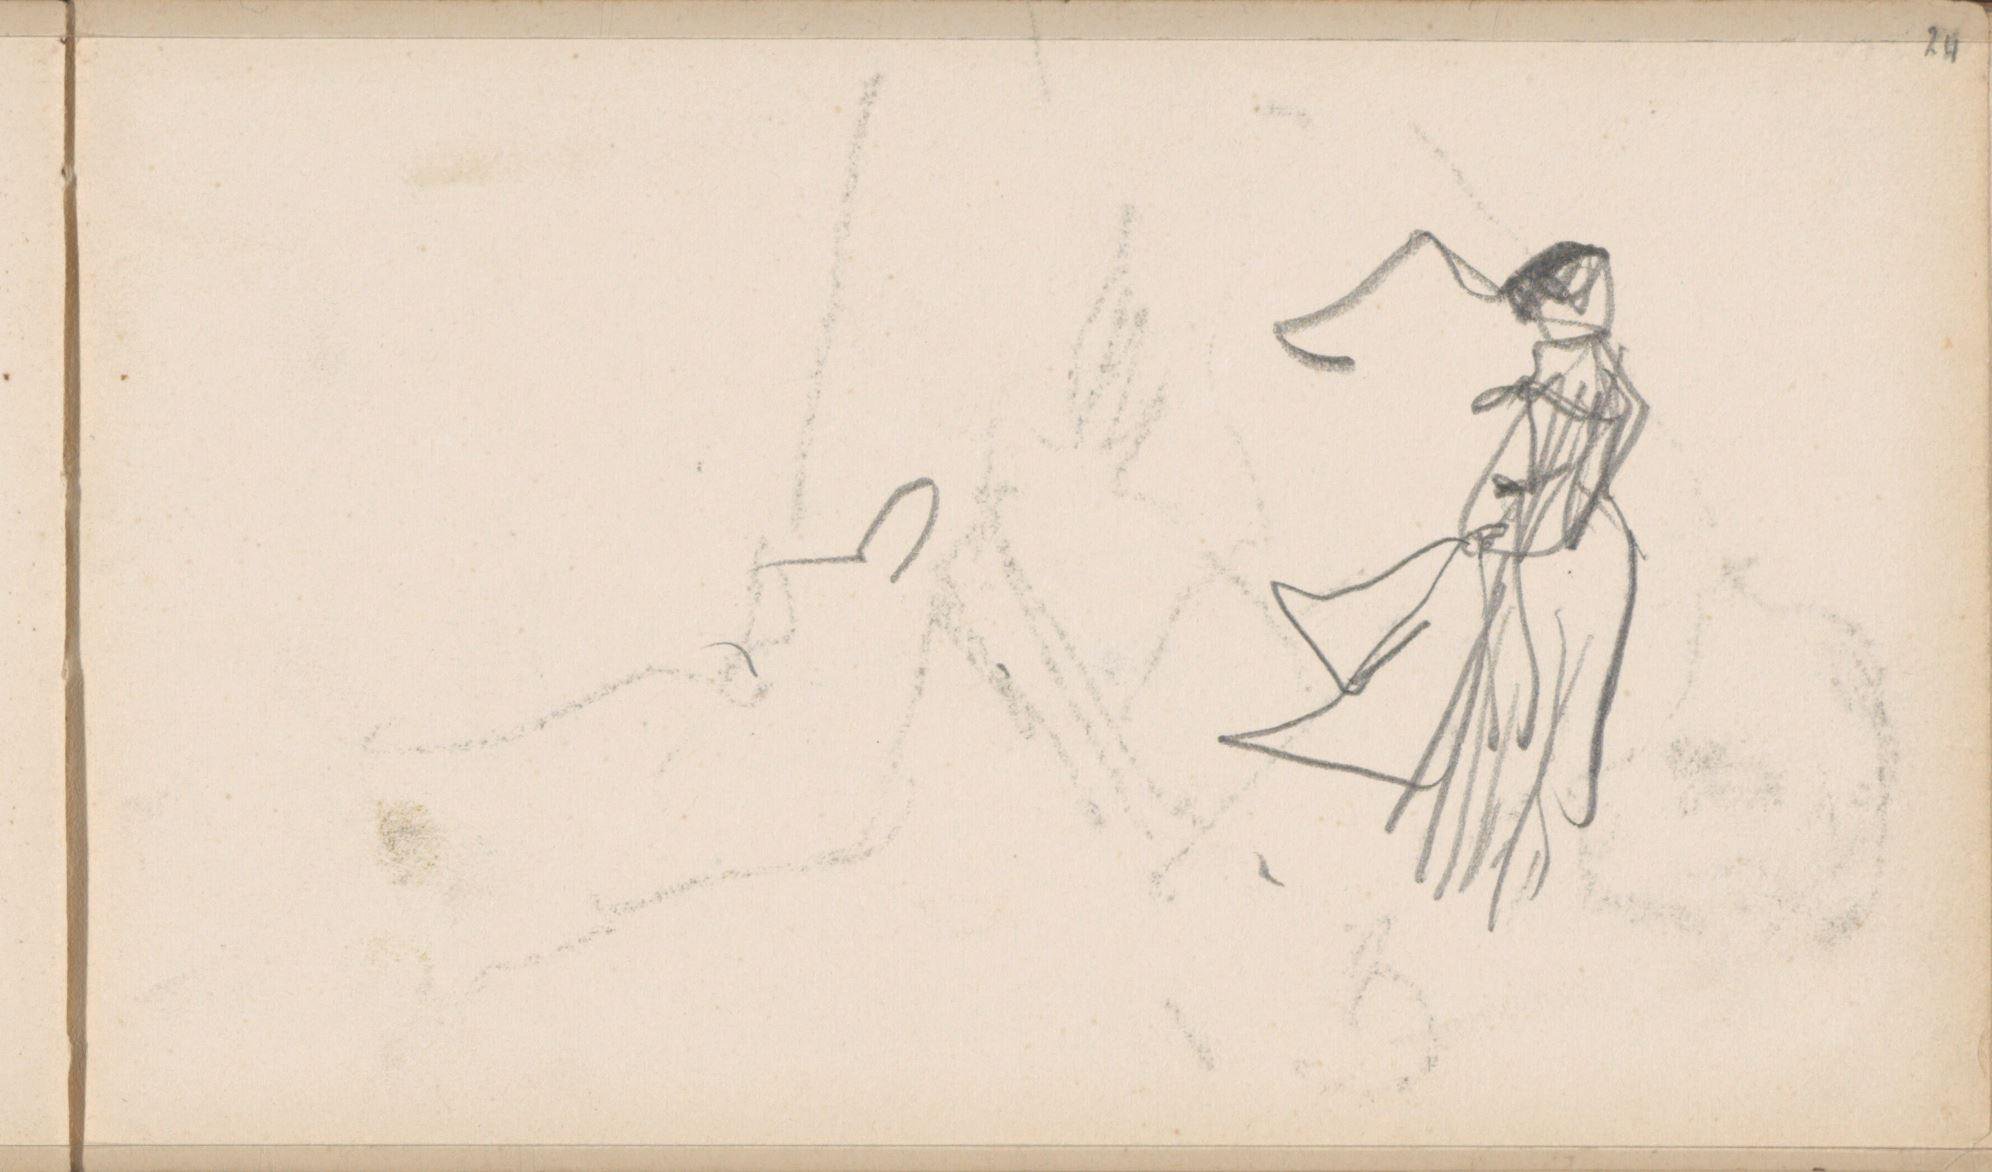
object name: sketchbook leaf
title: Figuurstudie, mogelijk van een staande vrouw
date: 1881-1883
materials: paper, pencil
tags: standing figure - aa - female human figure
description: Pagina 24 uit een schetsboek met 30 bladen.